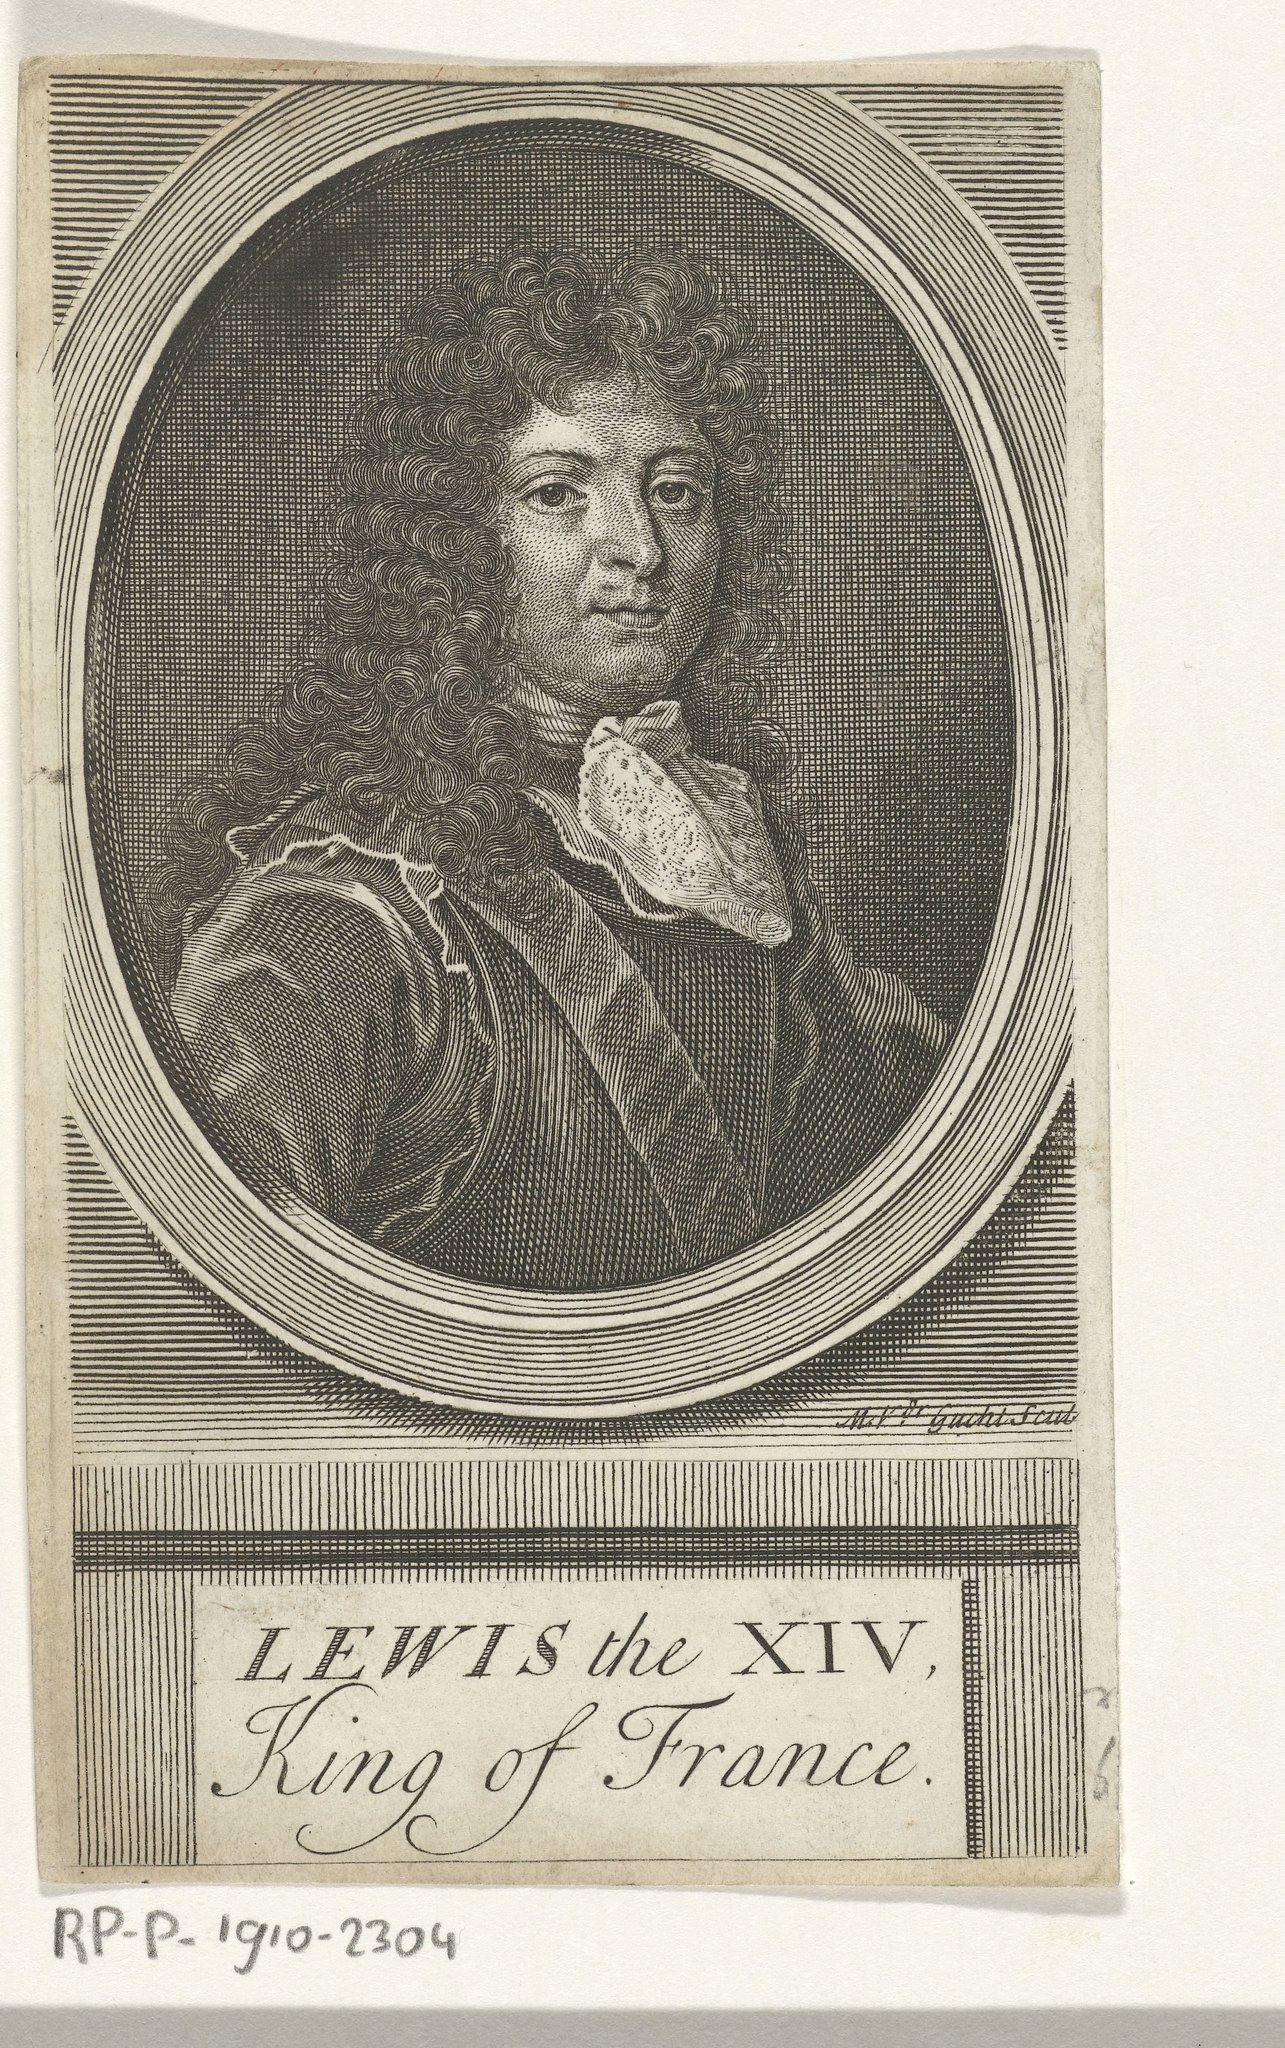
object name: print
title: Portret van Lodewijk XIV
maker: michiel van der gucht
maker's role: print maker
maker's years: 1660-1725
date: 1670-1725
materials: paper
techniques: engraving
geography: antwerp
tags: lodewijk xiv (koning van frankrijk)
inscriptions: collector's mark: Lugt 2228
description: Busteportret van Lodewijk XIV. Het portret is gevat in een ovale omlijsting. In de marge de naam en functie van de geportretteerde.